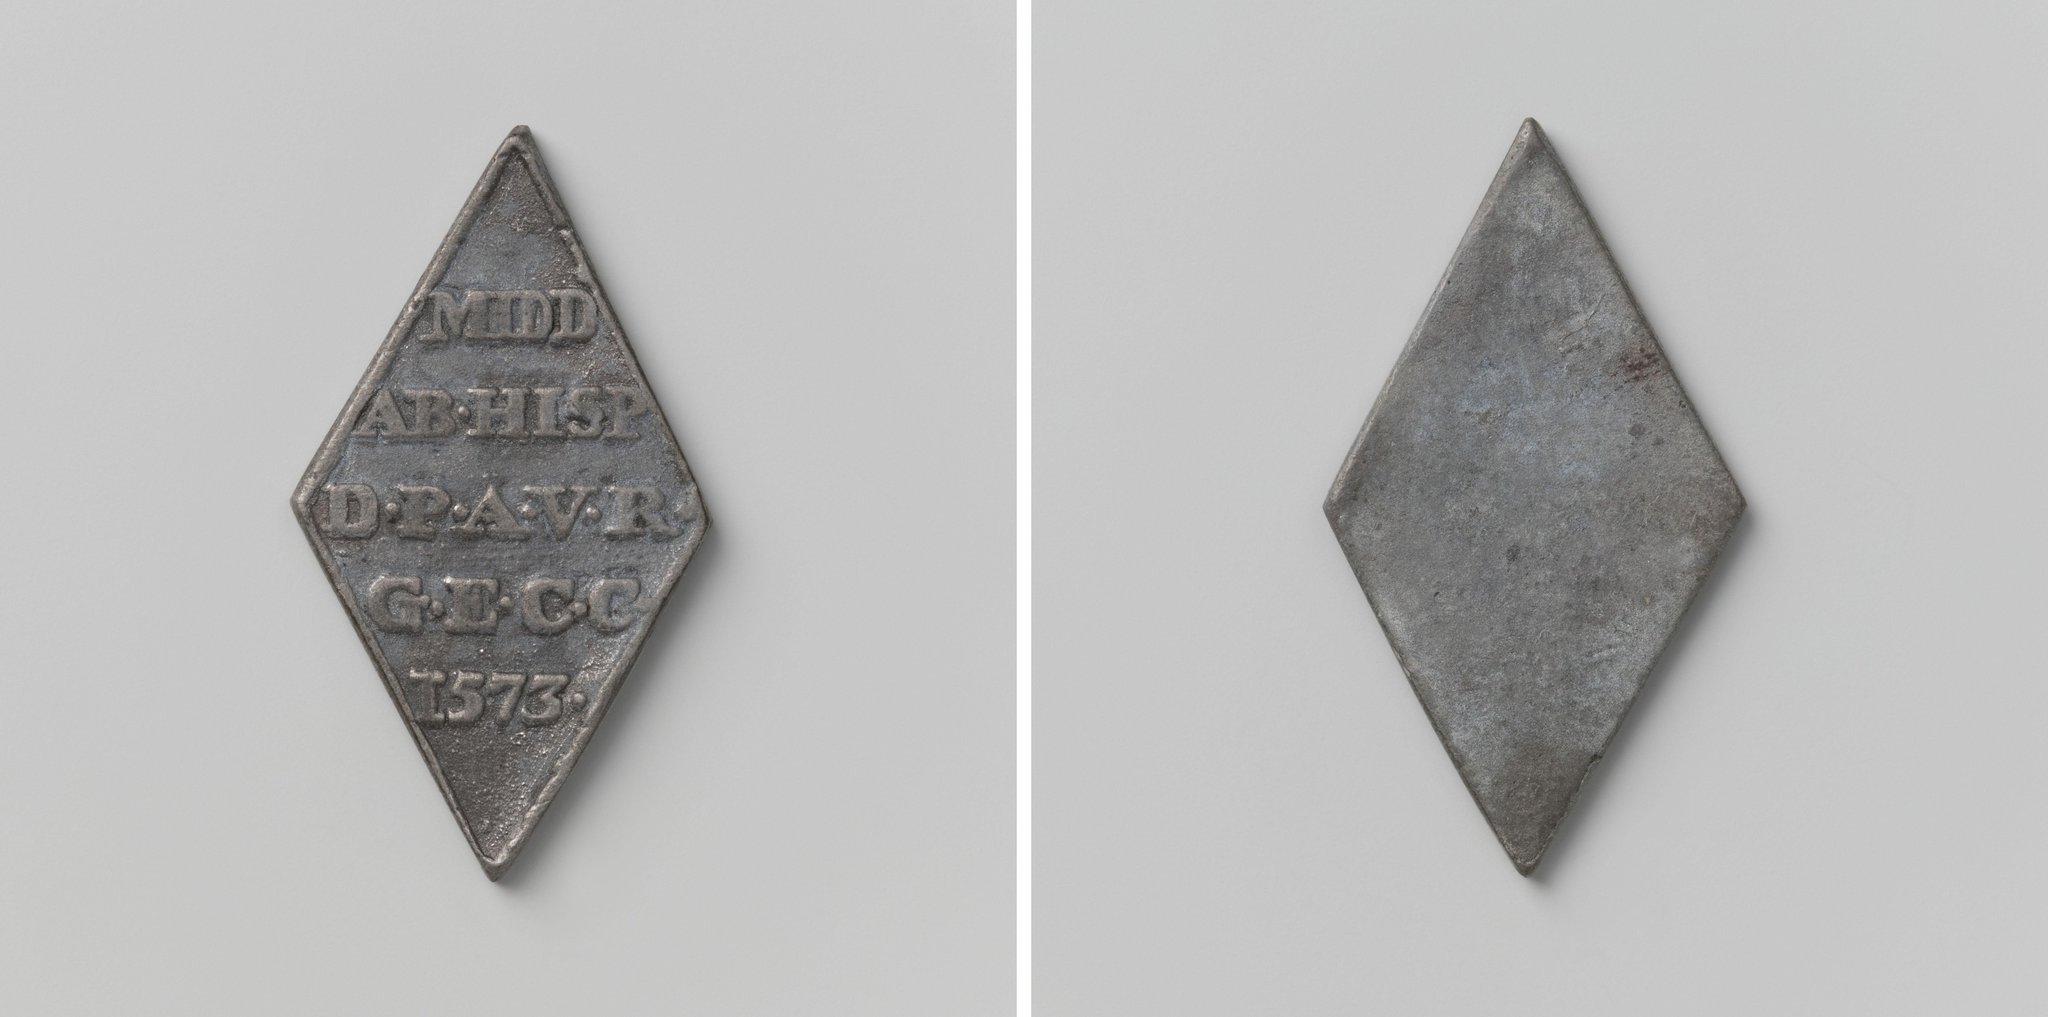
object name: medal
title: Penning over het beleg van Middelburg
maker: Anonymous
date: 1573-1883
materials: lead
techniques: striking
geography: netherlands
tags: middelburg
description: Eenzijdige loden ruitvormige penning. Voorzijde: opschrift. Keerzijde: blanco.